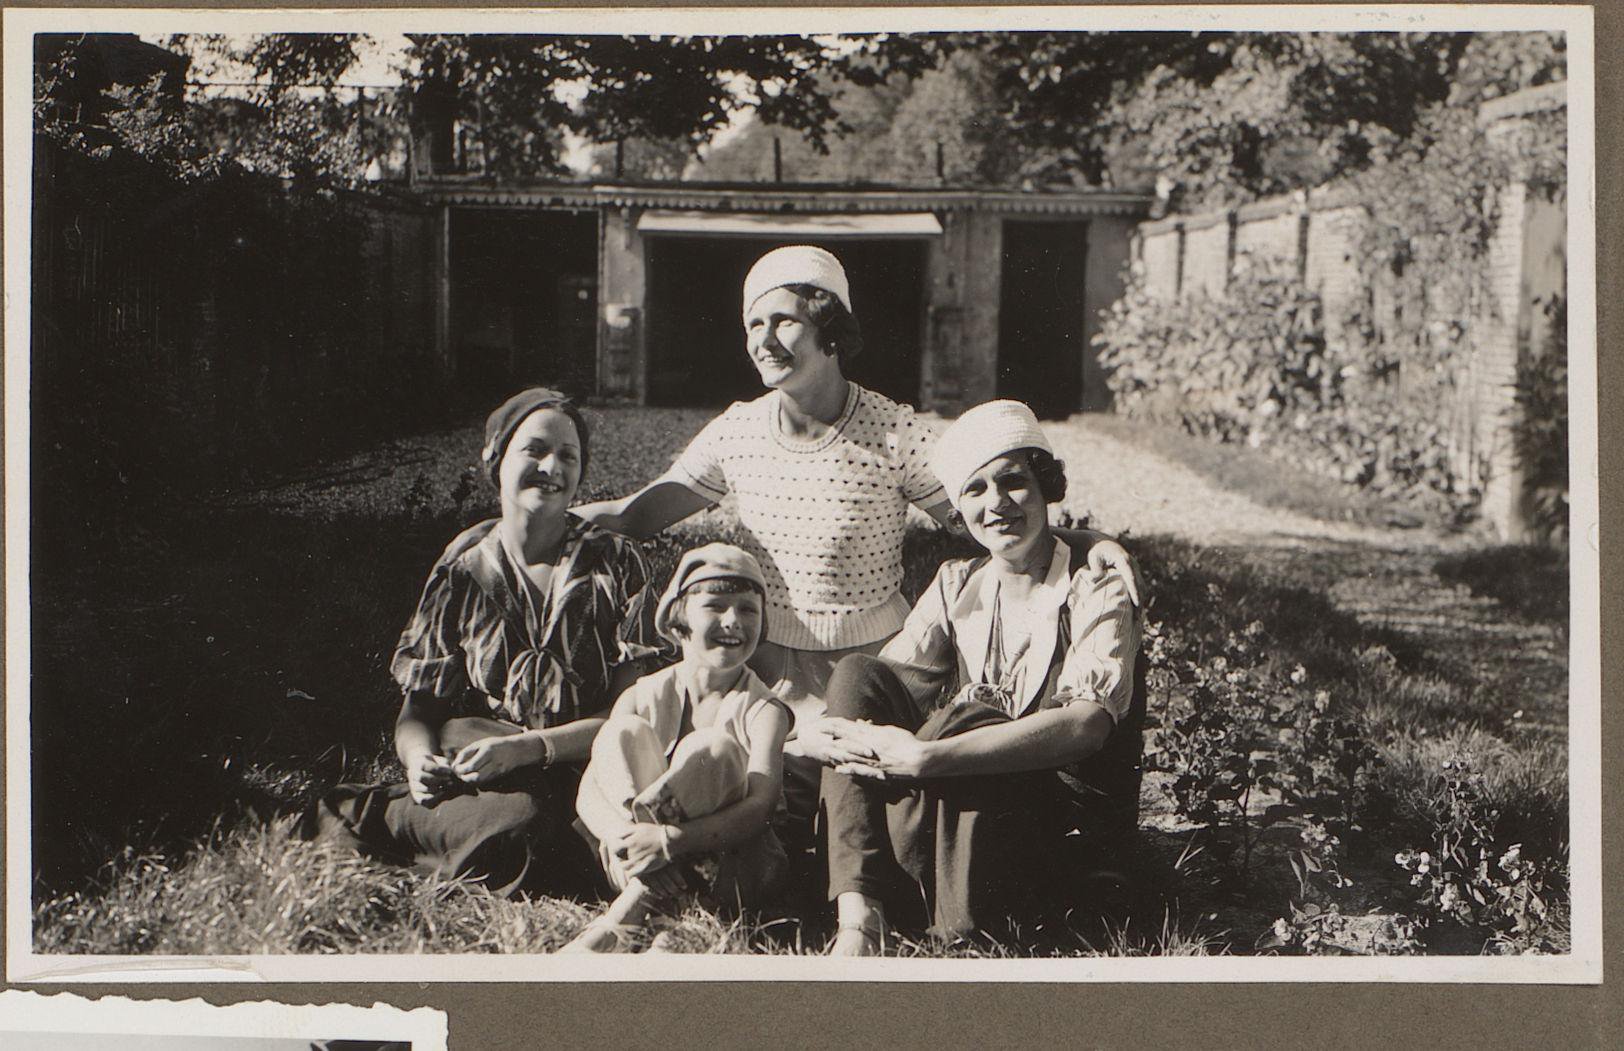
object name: photograph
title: Wilhelmina van Zijll de Jong met twee vrouwen en een meisje in een tuin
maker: Anonymous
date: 1933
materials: paper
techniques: gelatin silver print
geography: the hague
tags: wilhelmina van zijll de jong, historical persons - bb - woman, the hague